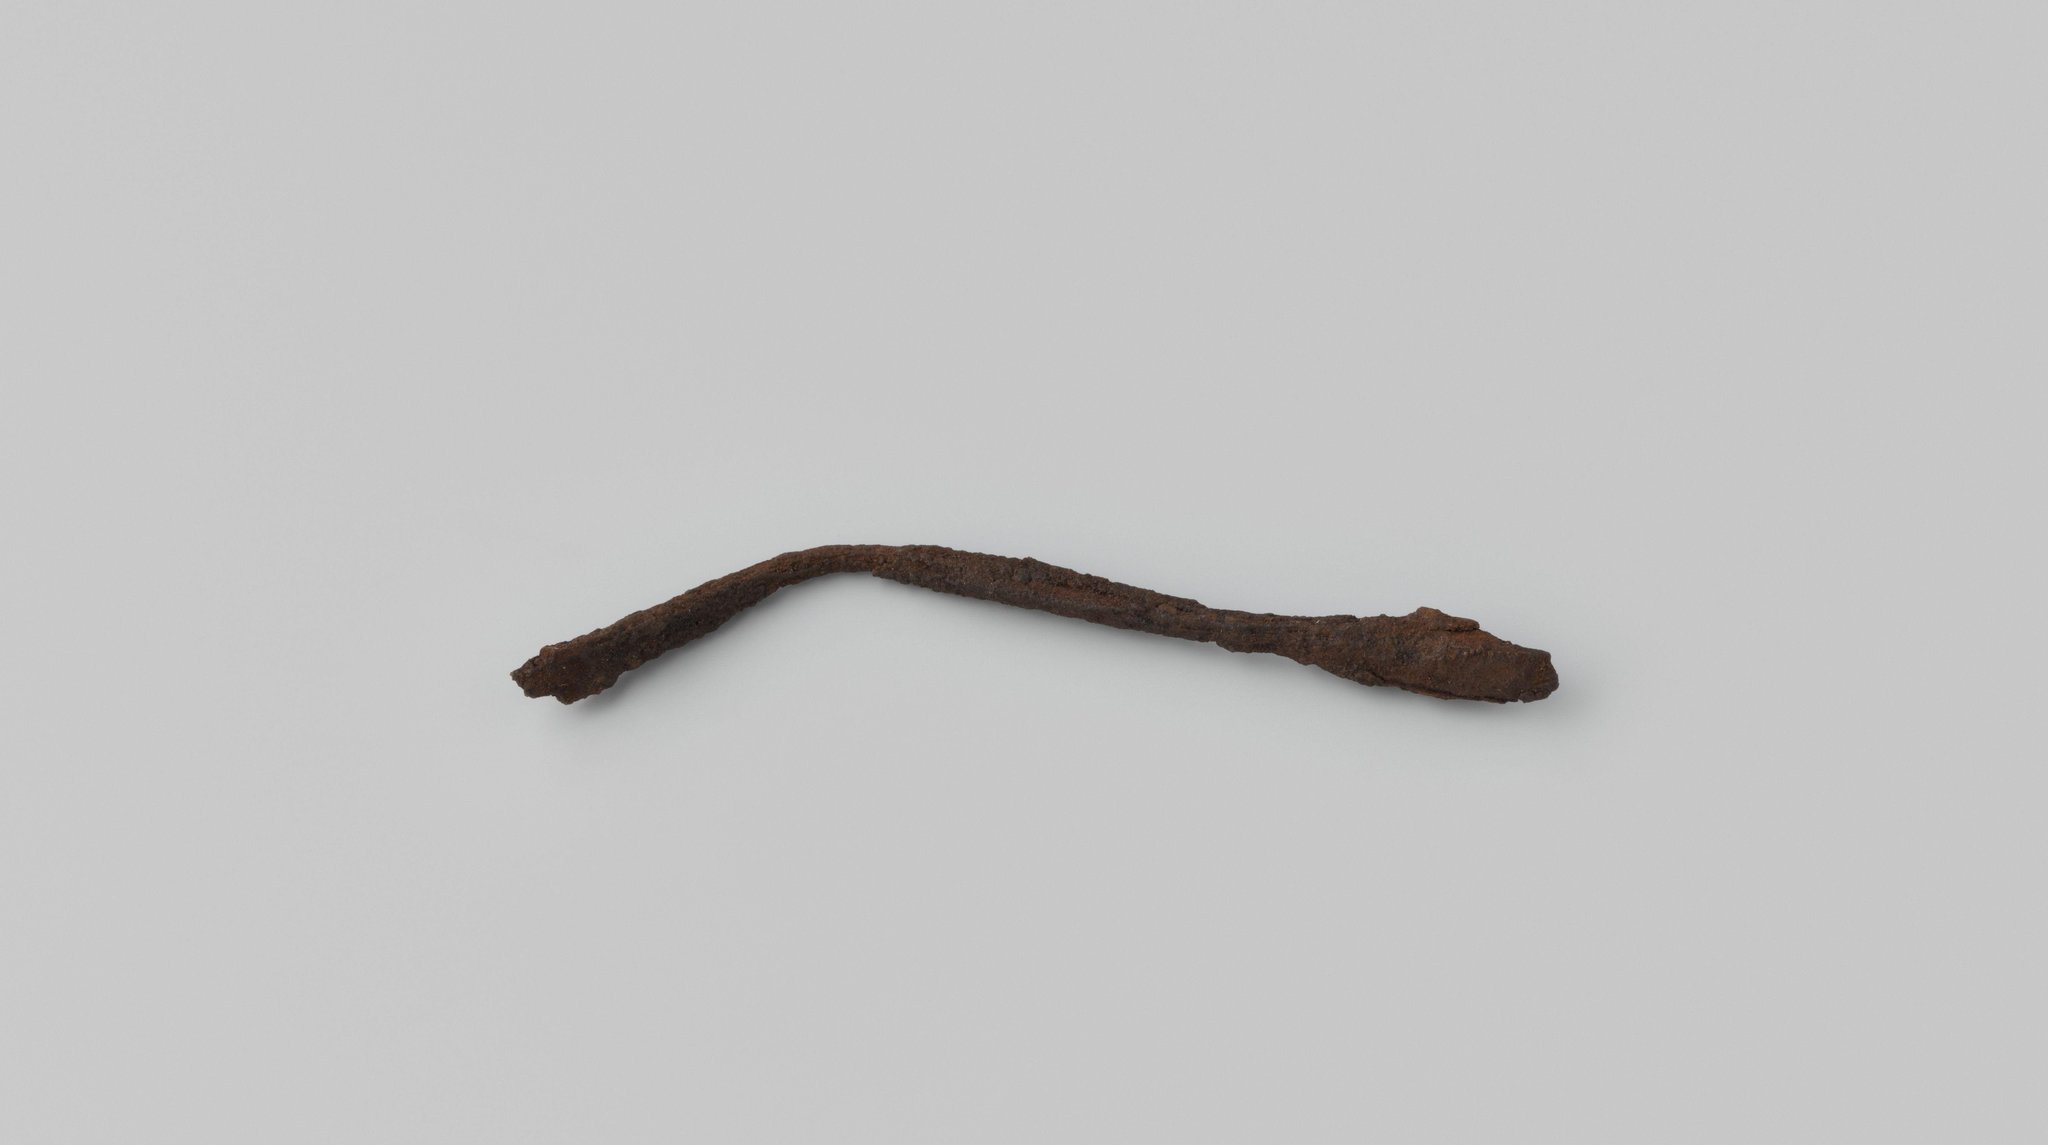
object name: part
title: Fragment of onderdeel uit het wrak van de Oost-Indiëvaarder Hollandia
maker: Anonymous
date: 1743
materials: iron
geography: netherlands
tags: verenigde oostindische compagnie, hollandia (schip), annet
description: Varied parts or fragments, bar(-shaped) fragments; fragm, eroded, broken rectangular in section, both ends widened amd flattened.